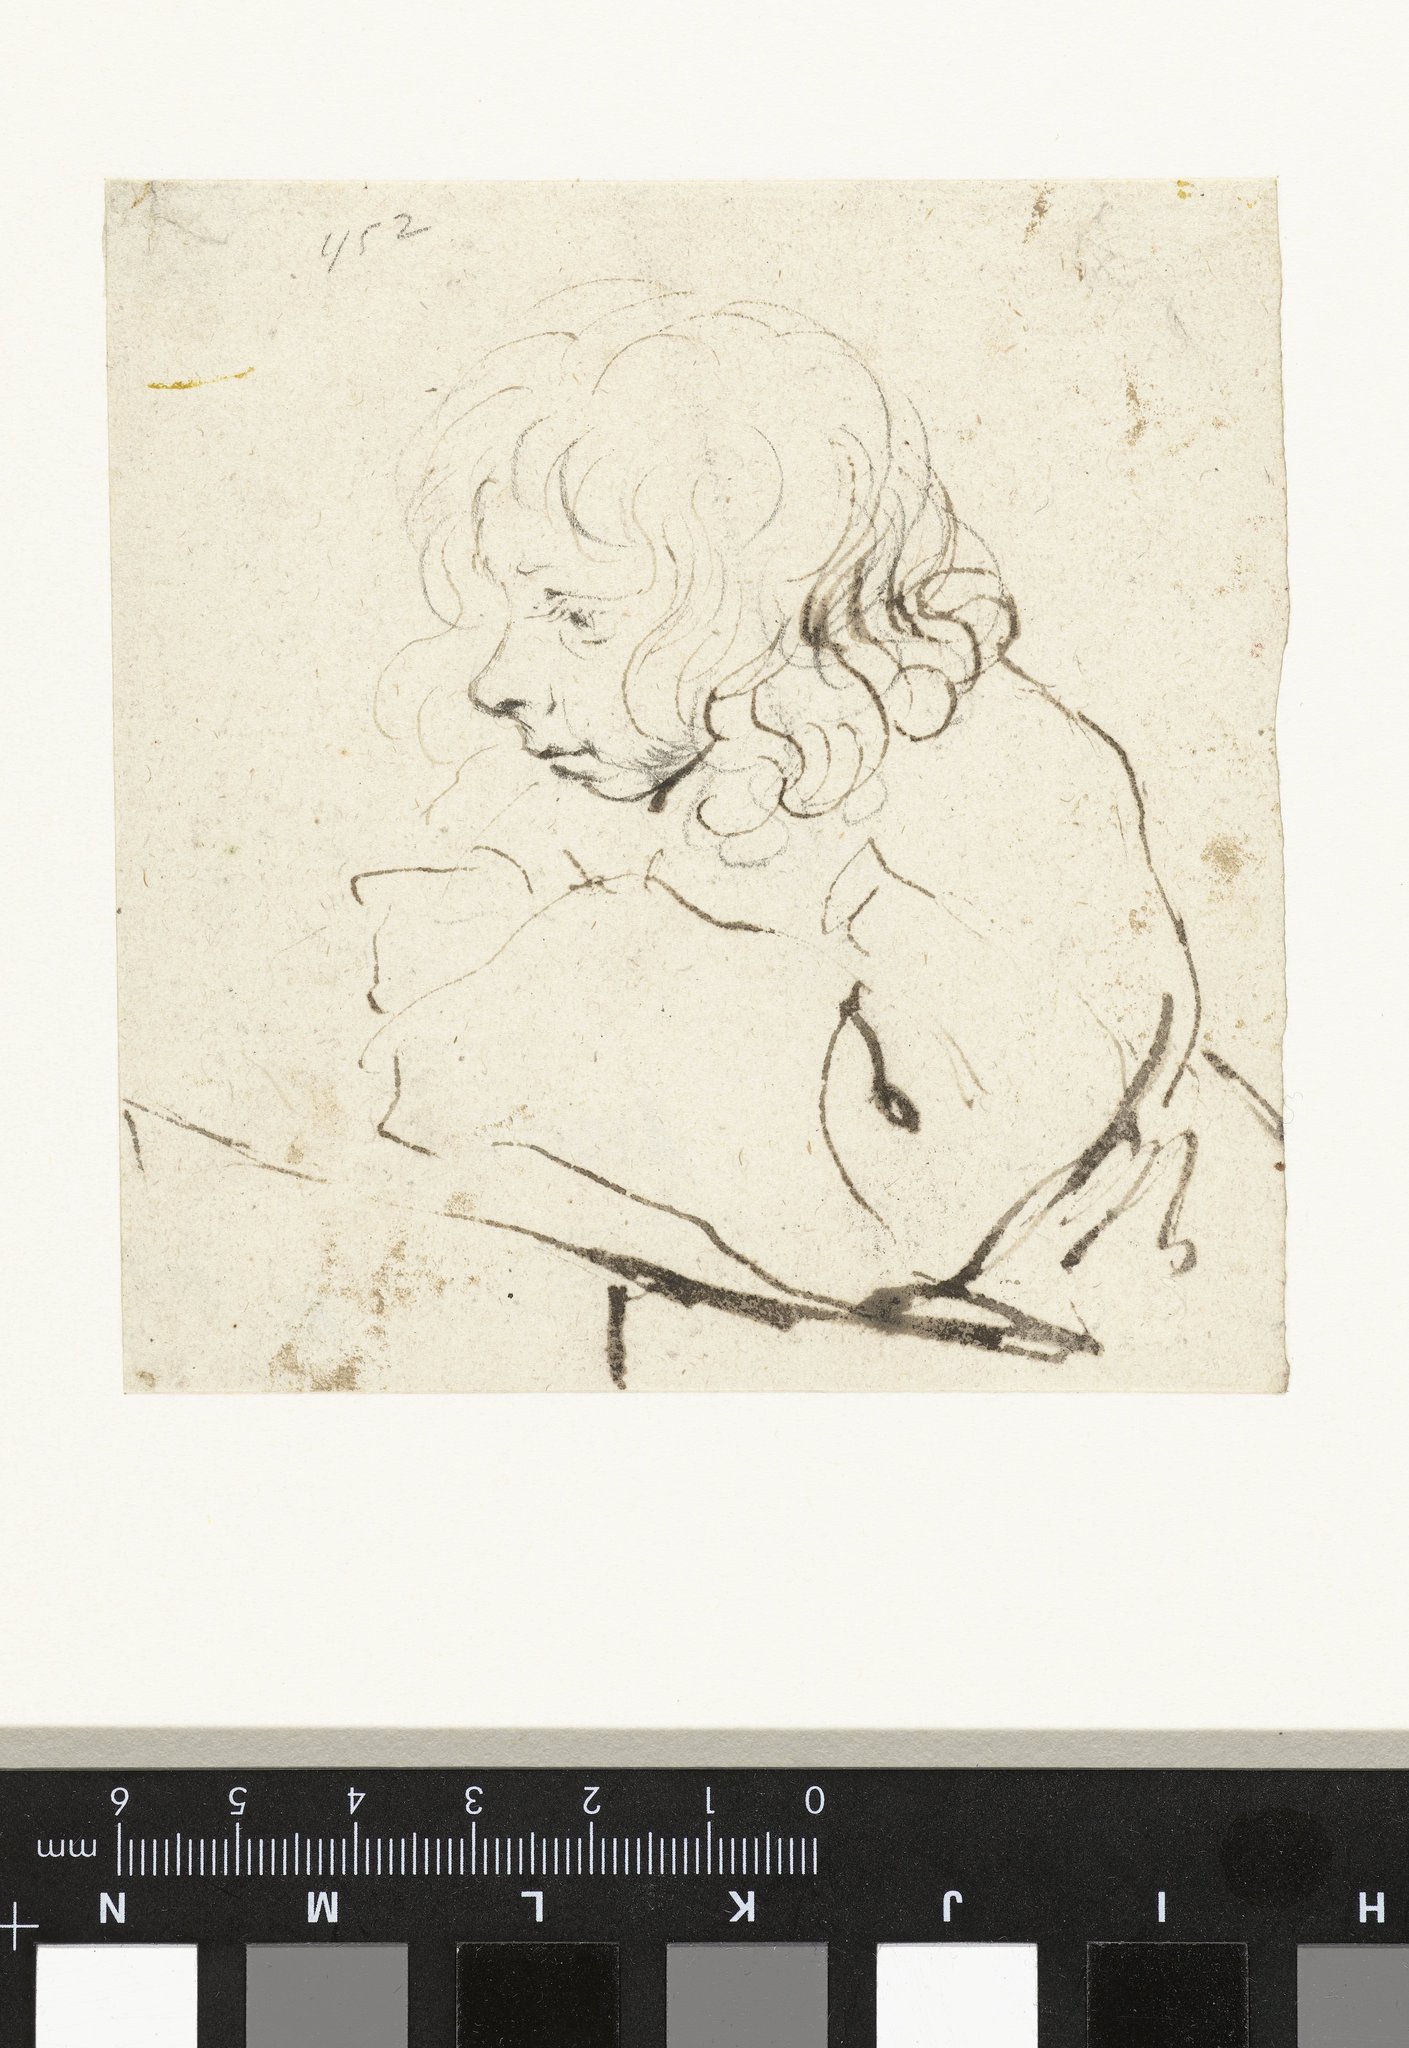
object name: drawing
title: Moses ter Borch, tekenend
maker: gerard ter borch (ii)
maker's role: draughtsman, painter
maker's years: 1617-1681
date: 1650-1655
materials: chalk, ink, paper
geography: zwolle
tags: moses ter borch